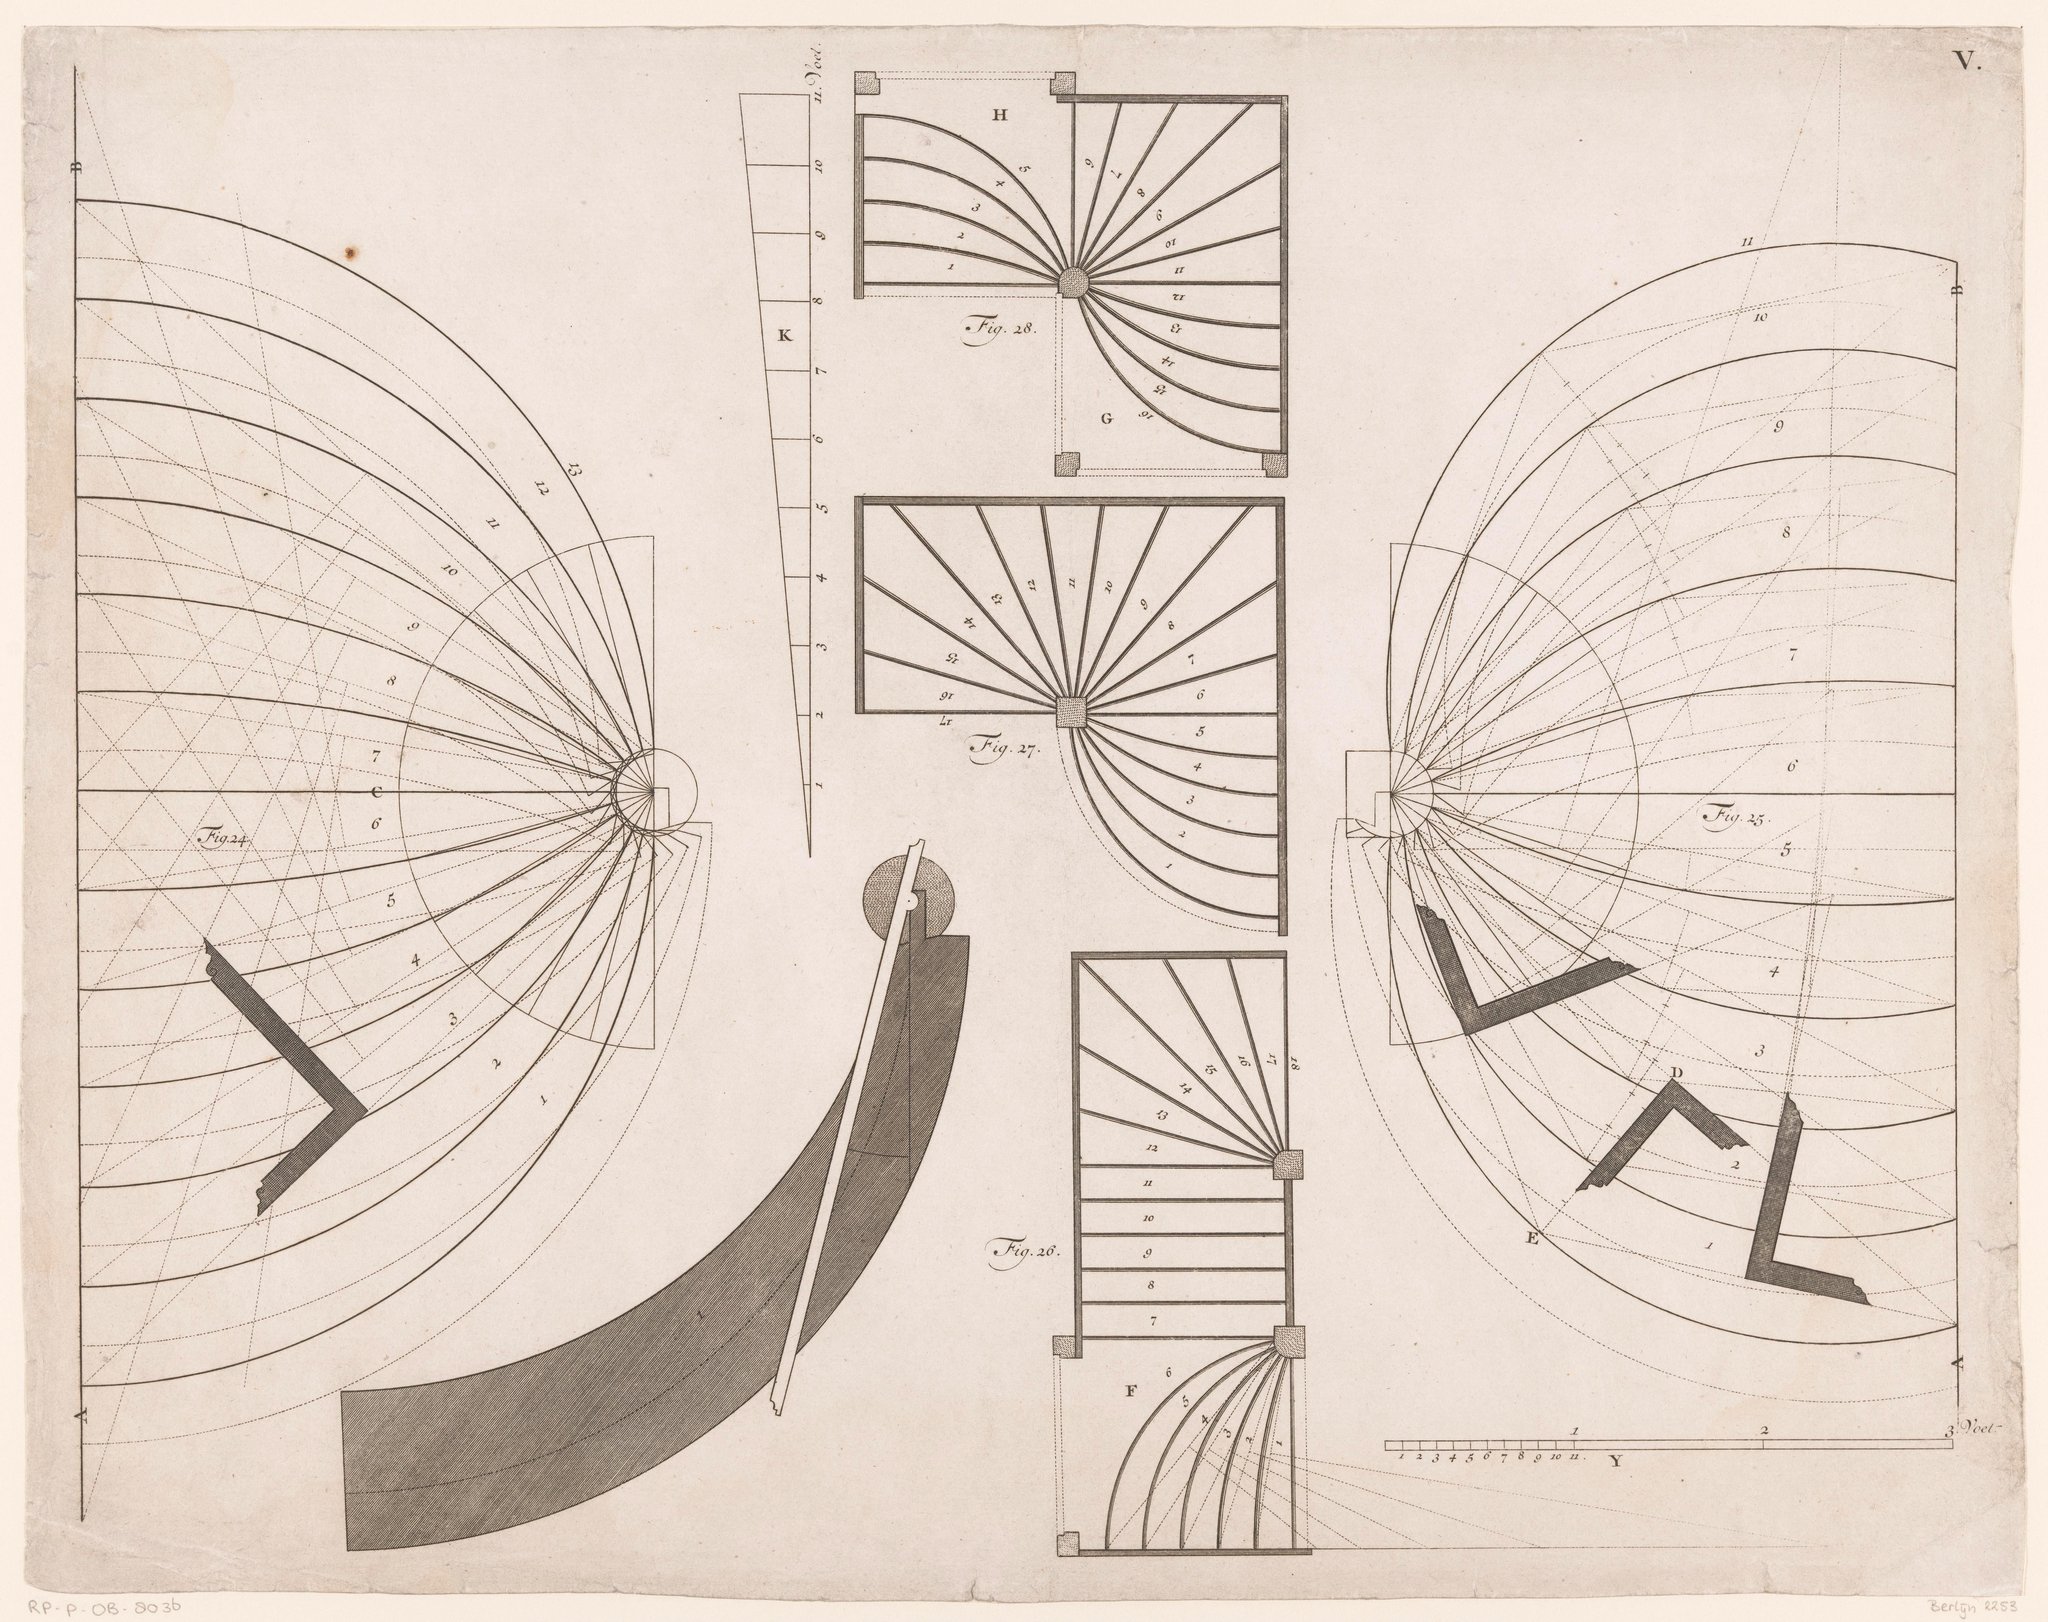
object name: print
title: Technische tekeningen van trappen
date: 1739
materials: paper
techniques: engraving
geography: amsterdam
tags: drawing (mathematics), staircase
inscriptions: collector's mark: Lugt 2228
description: Technische tekeningen van spiltrappen en een trap met onverdreven kwarten (nummers 24 tot en met 28). Bovenaanzichten.